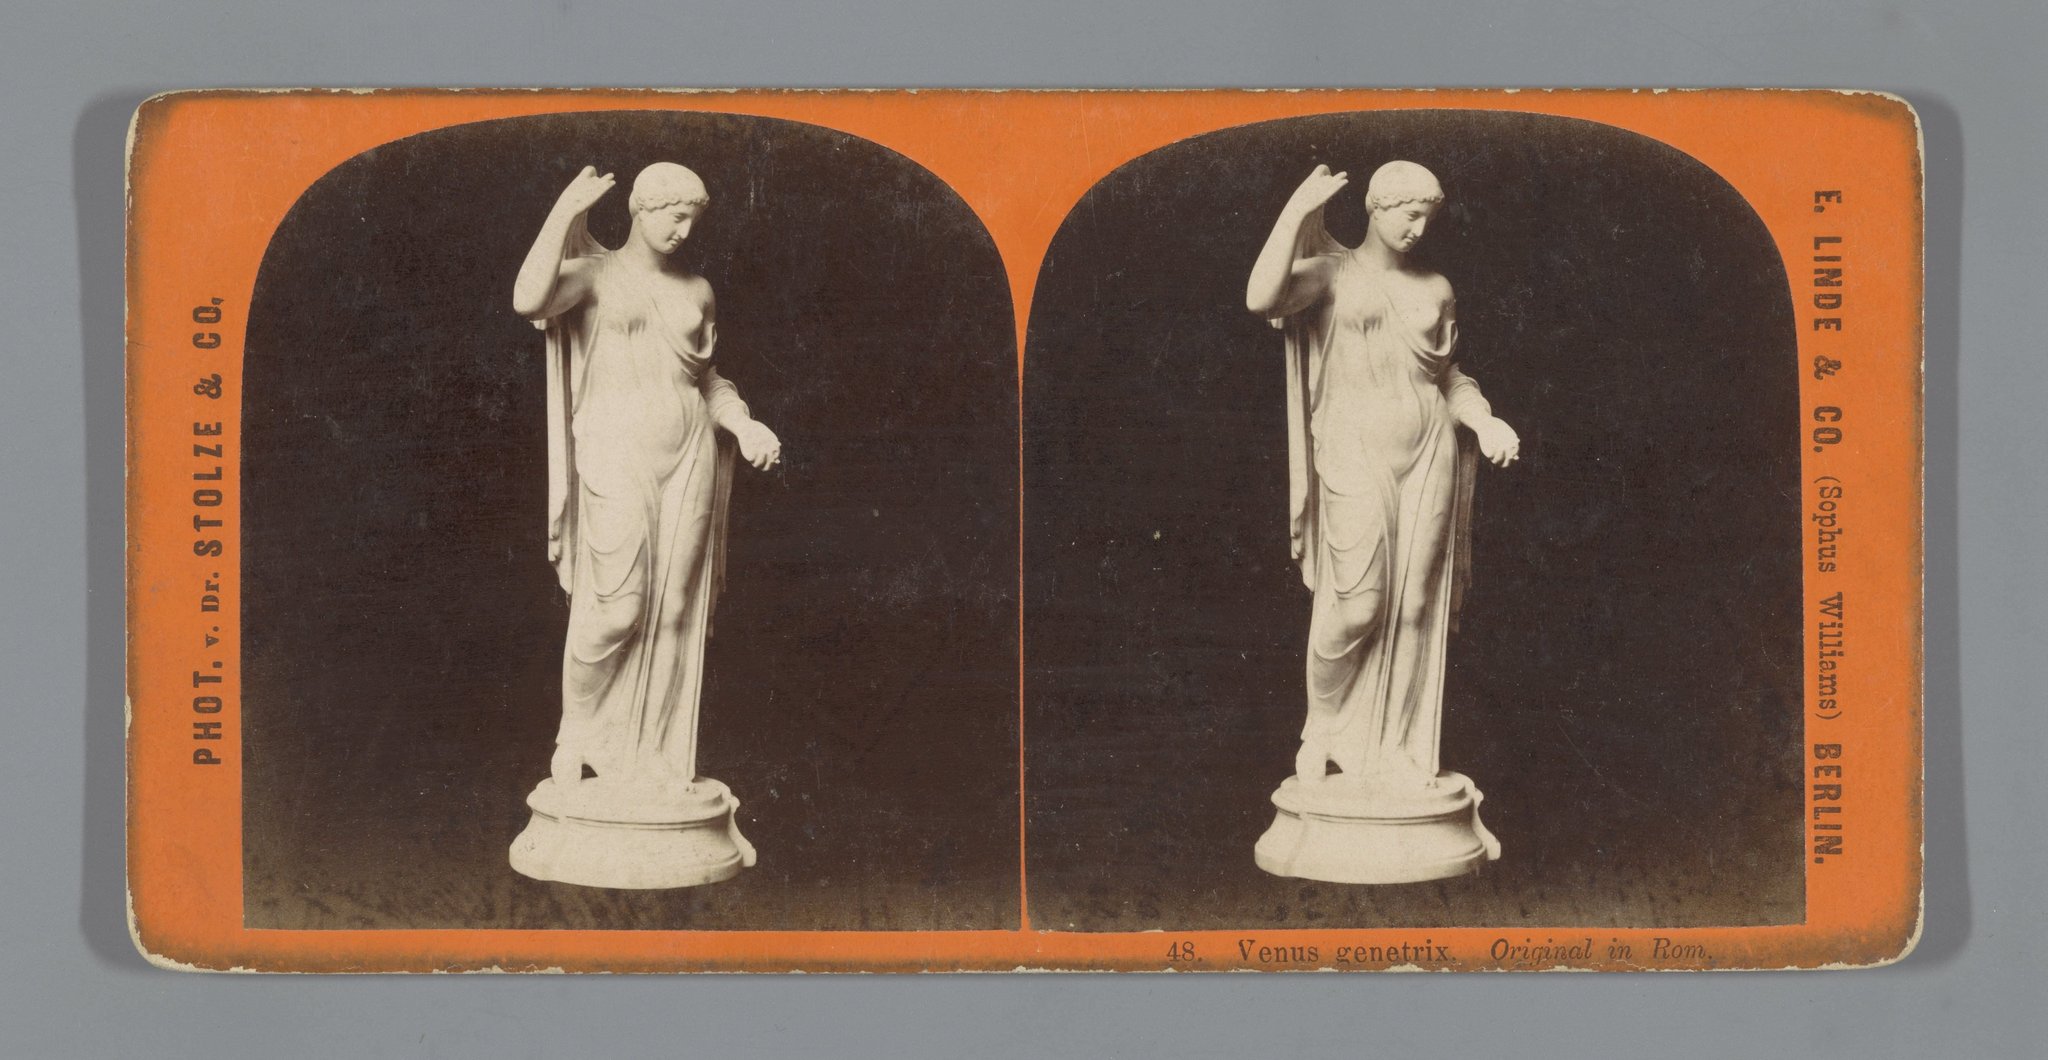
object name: stereograph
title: Sculptuur van Venus als moedergodin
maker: karl heinrich franz stolze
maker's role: fotograaf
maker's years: 1836-1910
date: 1855-1890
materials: cardboard, photographic support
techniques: albumen print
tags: (story of) venus (aphrodite), sculpture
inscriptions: : ‘Berlin’, number: ‘48’